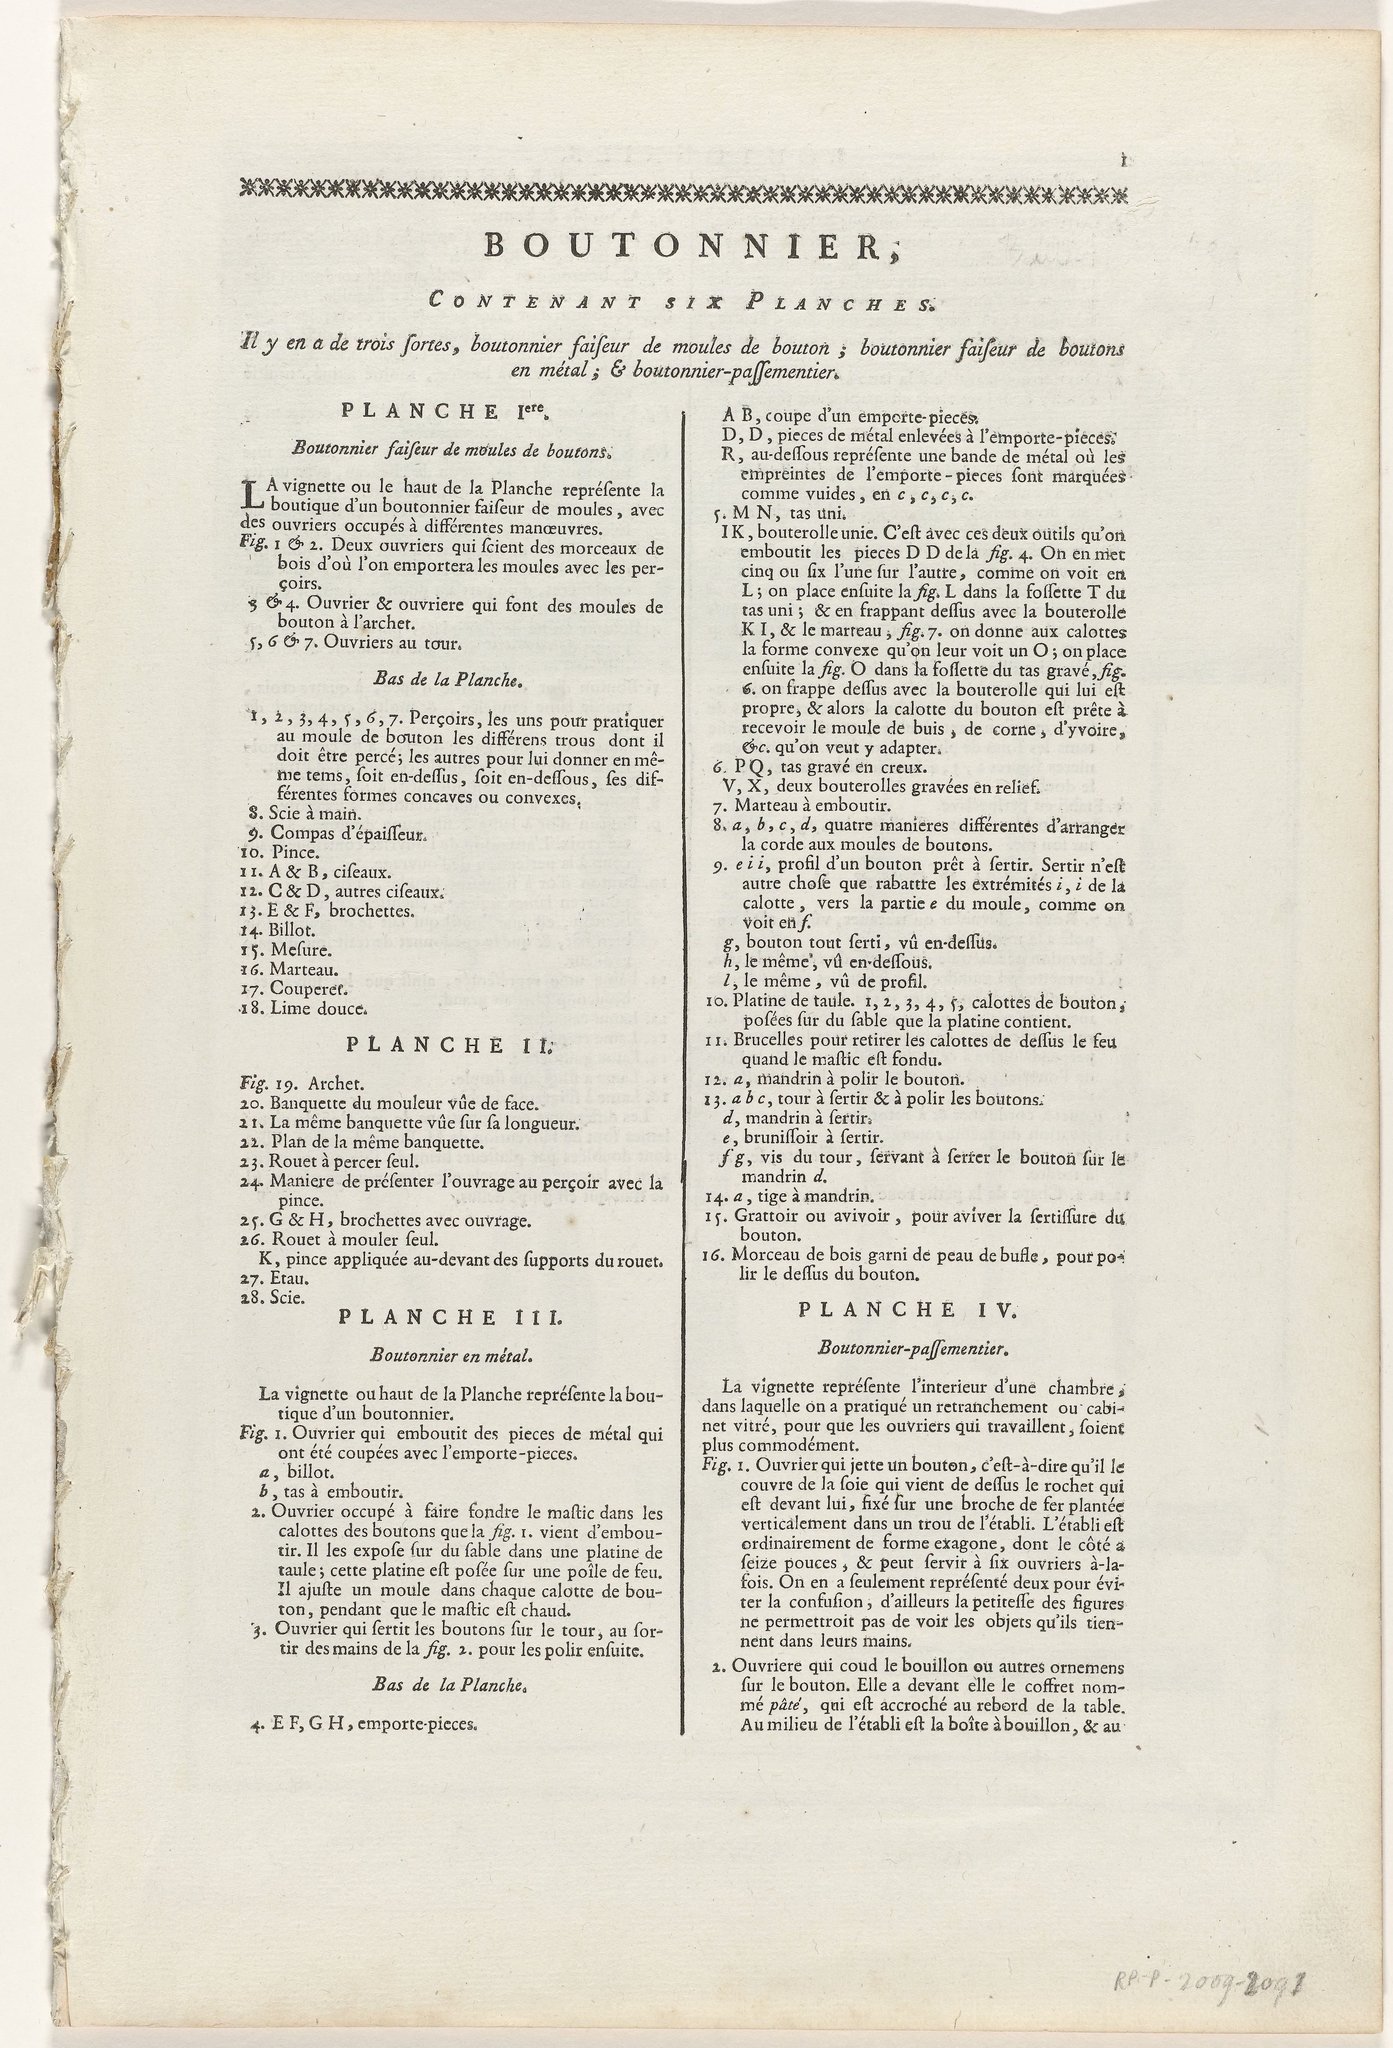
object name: print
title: Encyclopédie de Diderot et d'Alembert 1751-1772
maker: Anonymous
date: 1751-1772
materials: paper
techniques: engraving, letterpress printing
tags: button, fashion plates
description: Over het maken van knopen: 7 pagina's en 6 planches. Uit Encyclopédie ou dictionnaire raisonné des sciences, des arts et des métiers door Denis Diderot en Jean Le Rond d'Alembert, Parijs, 1751-1772.